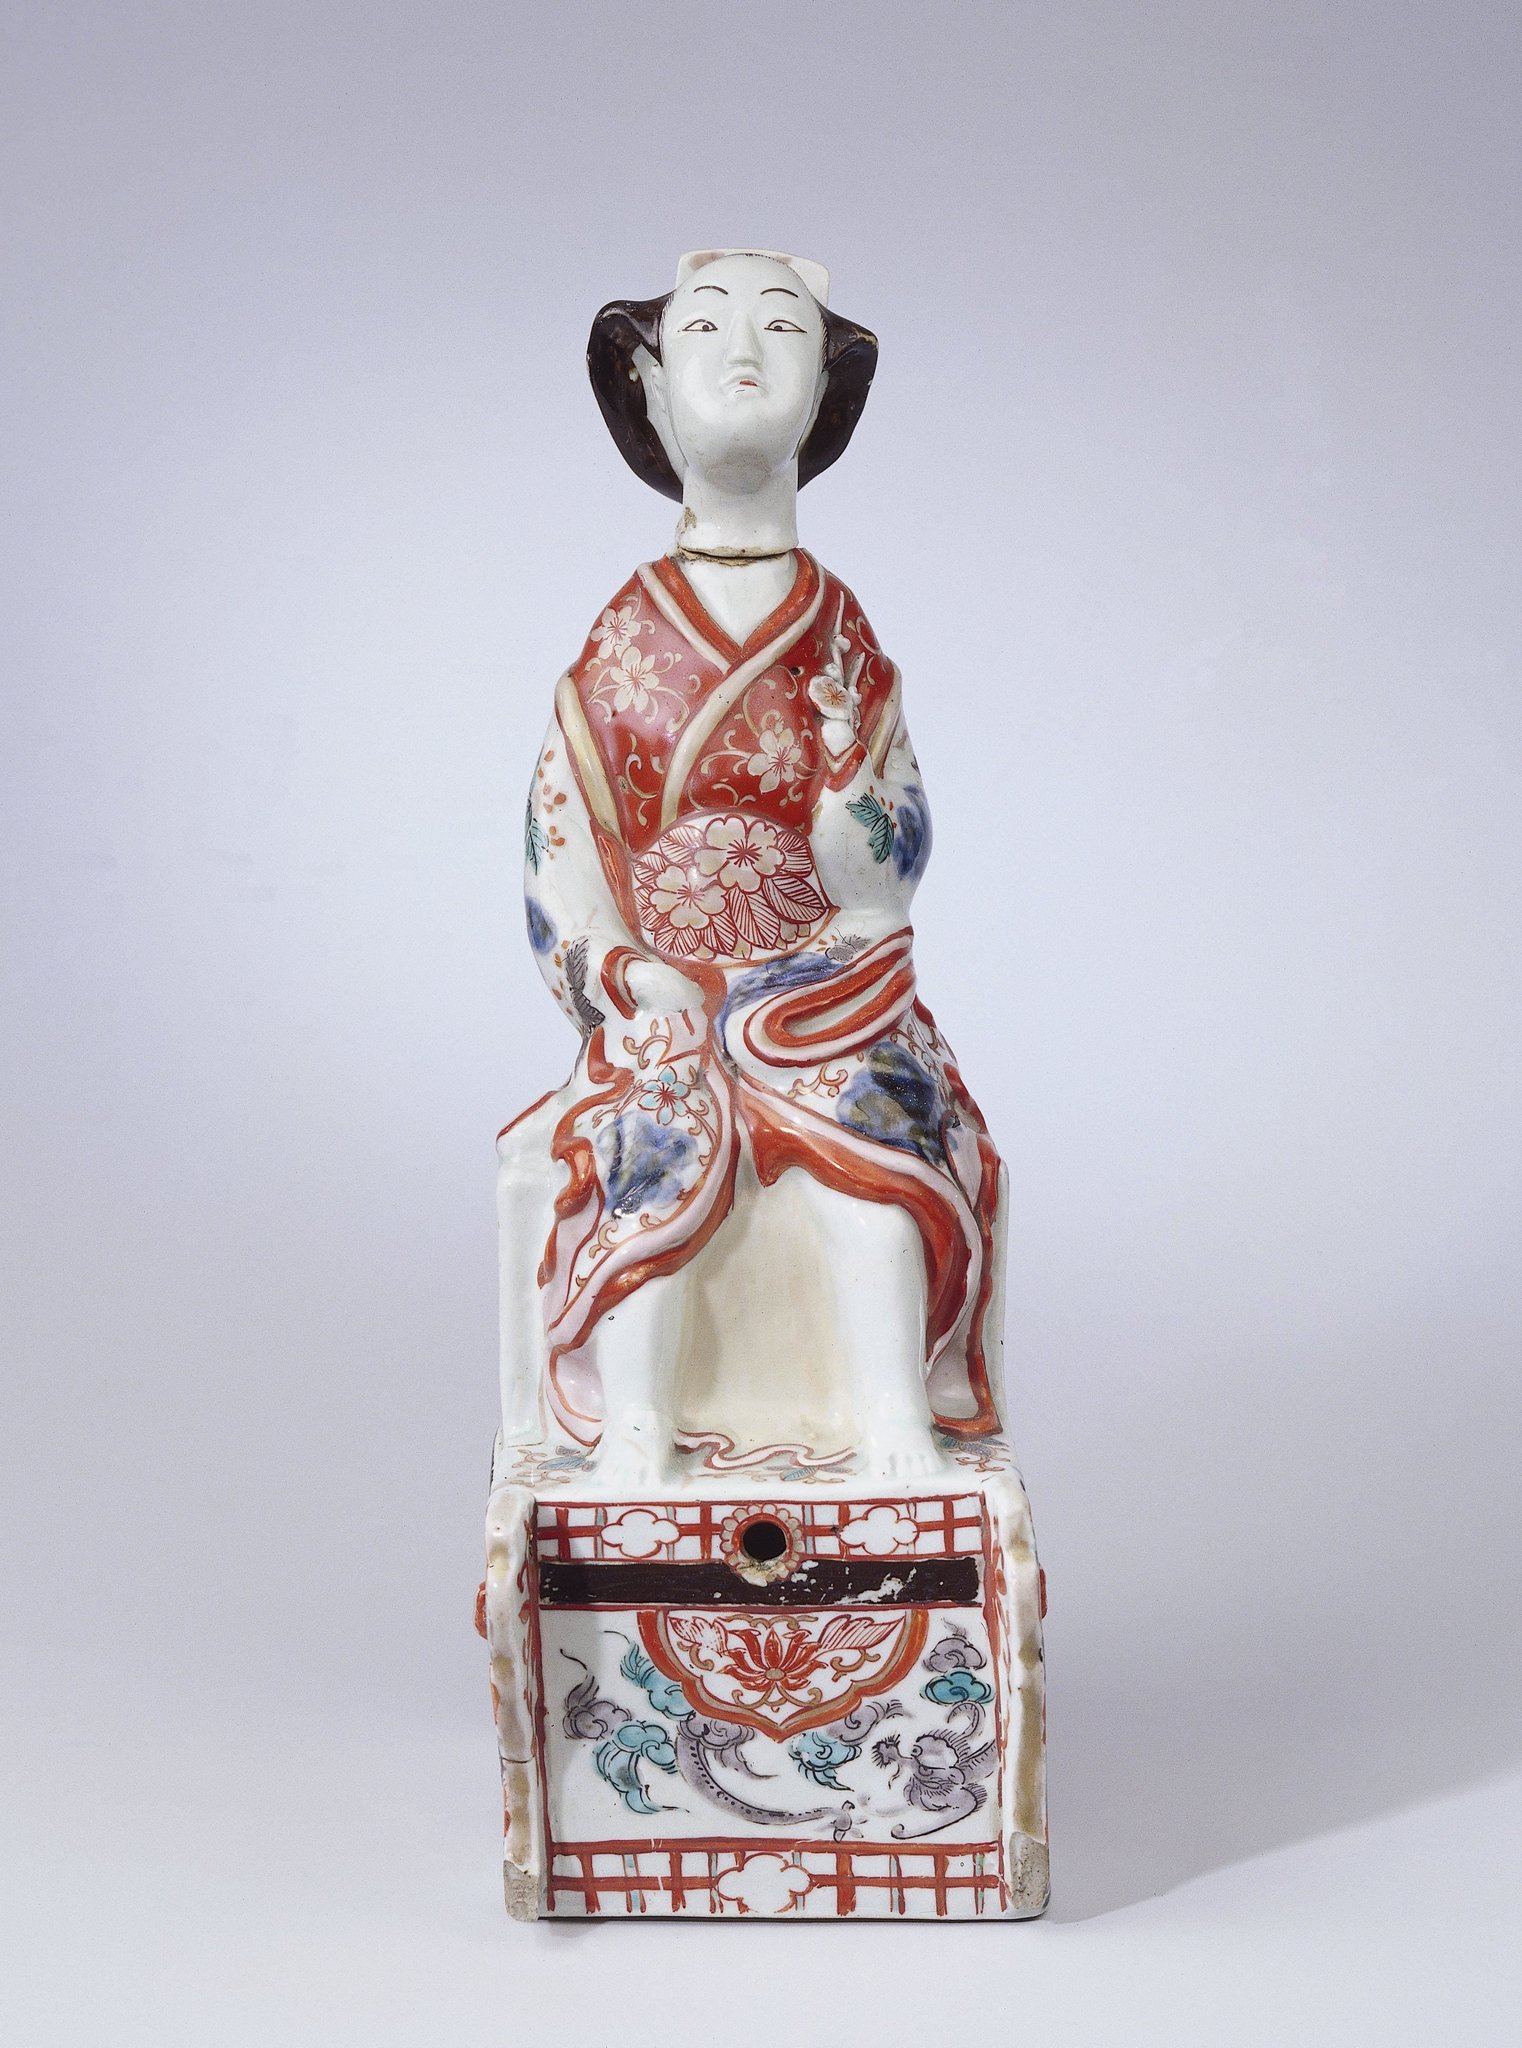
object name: figure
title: Spirit keg in the shape of a Japanese woman on a chariot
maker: Anonymous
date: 1700-1730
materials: cobalt, glaze, gold, paint, porcelain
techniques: firing, forming, gilding, vitrification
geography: japan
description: Bottle. Japan, Arita. Ca. 1700. Porcelain, European decoration in enamels. Figure of woman on chariot. Japan, Arita. Ca. 1700. Porcelain, decoration in underglaze blue and enamels.